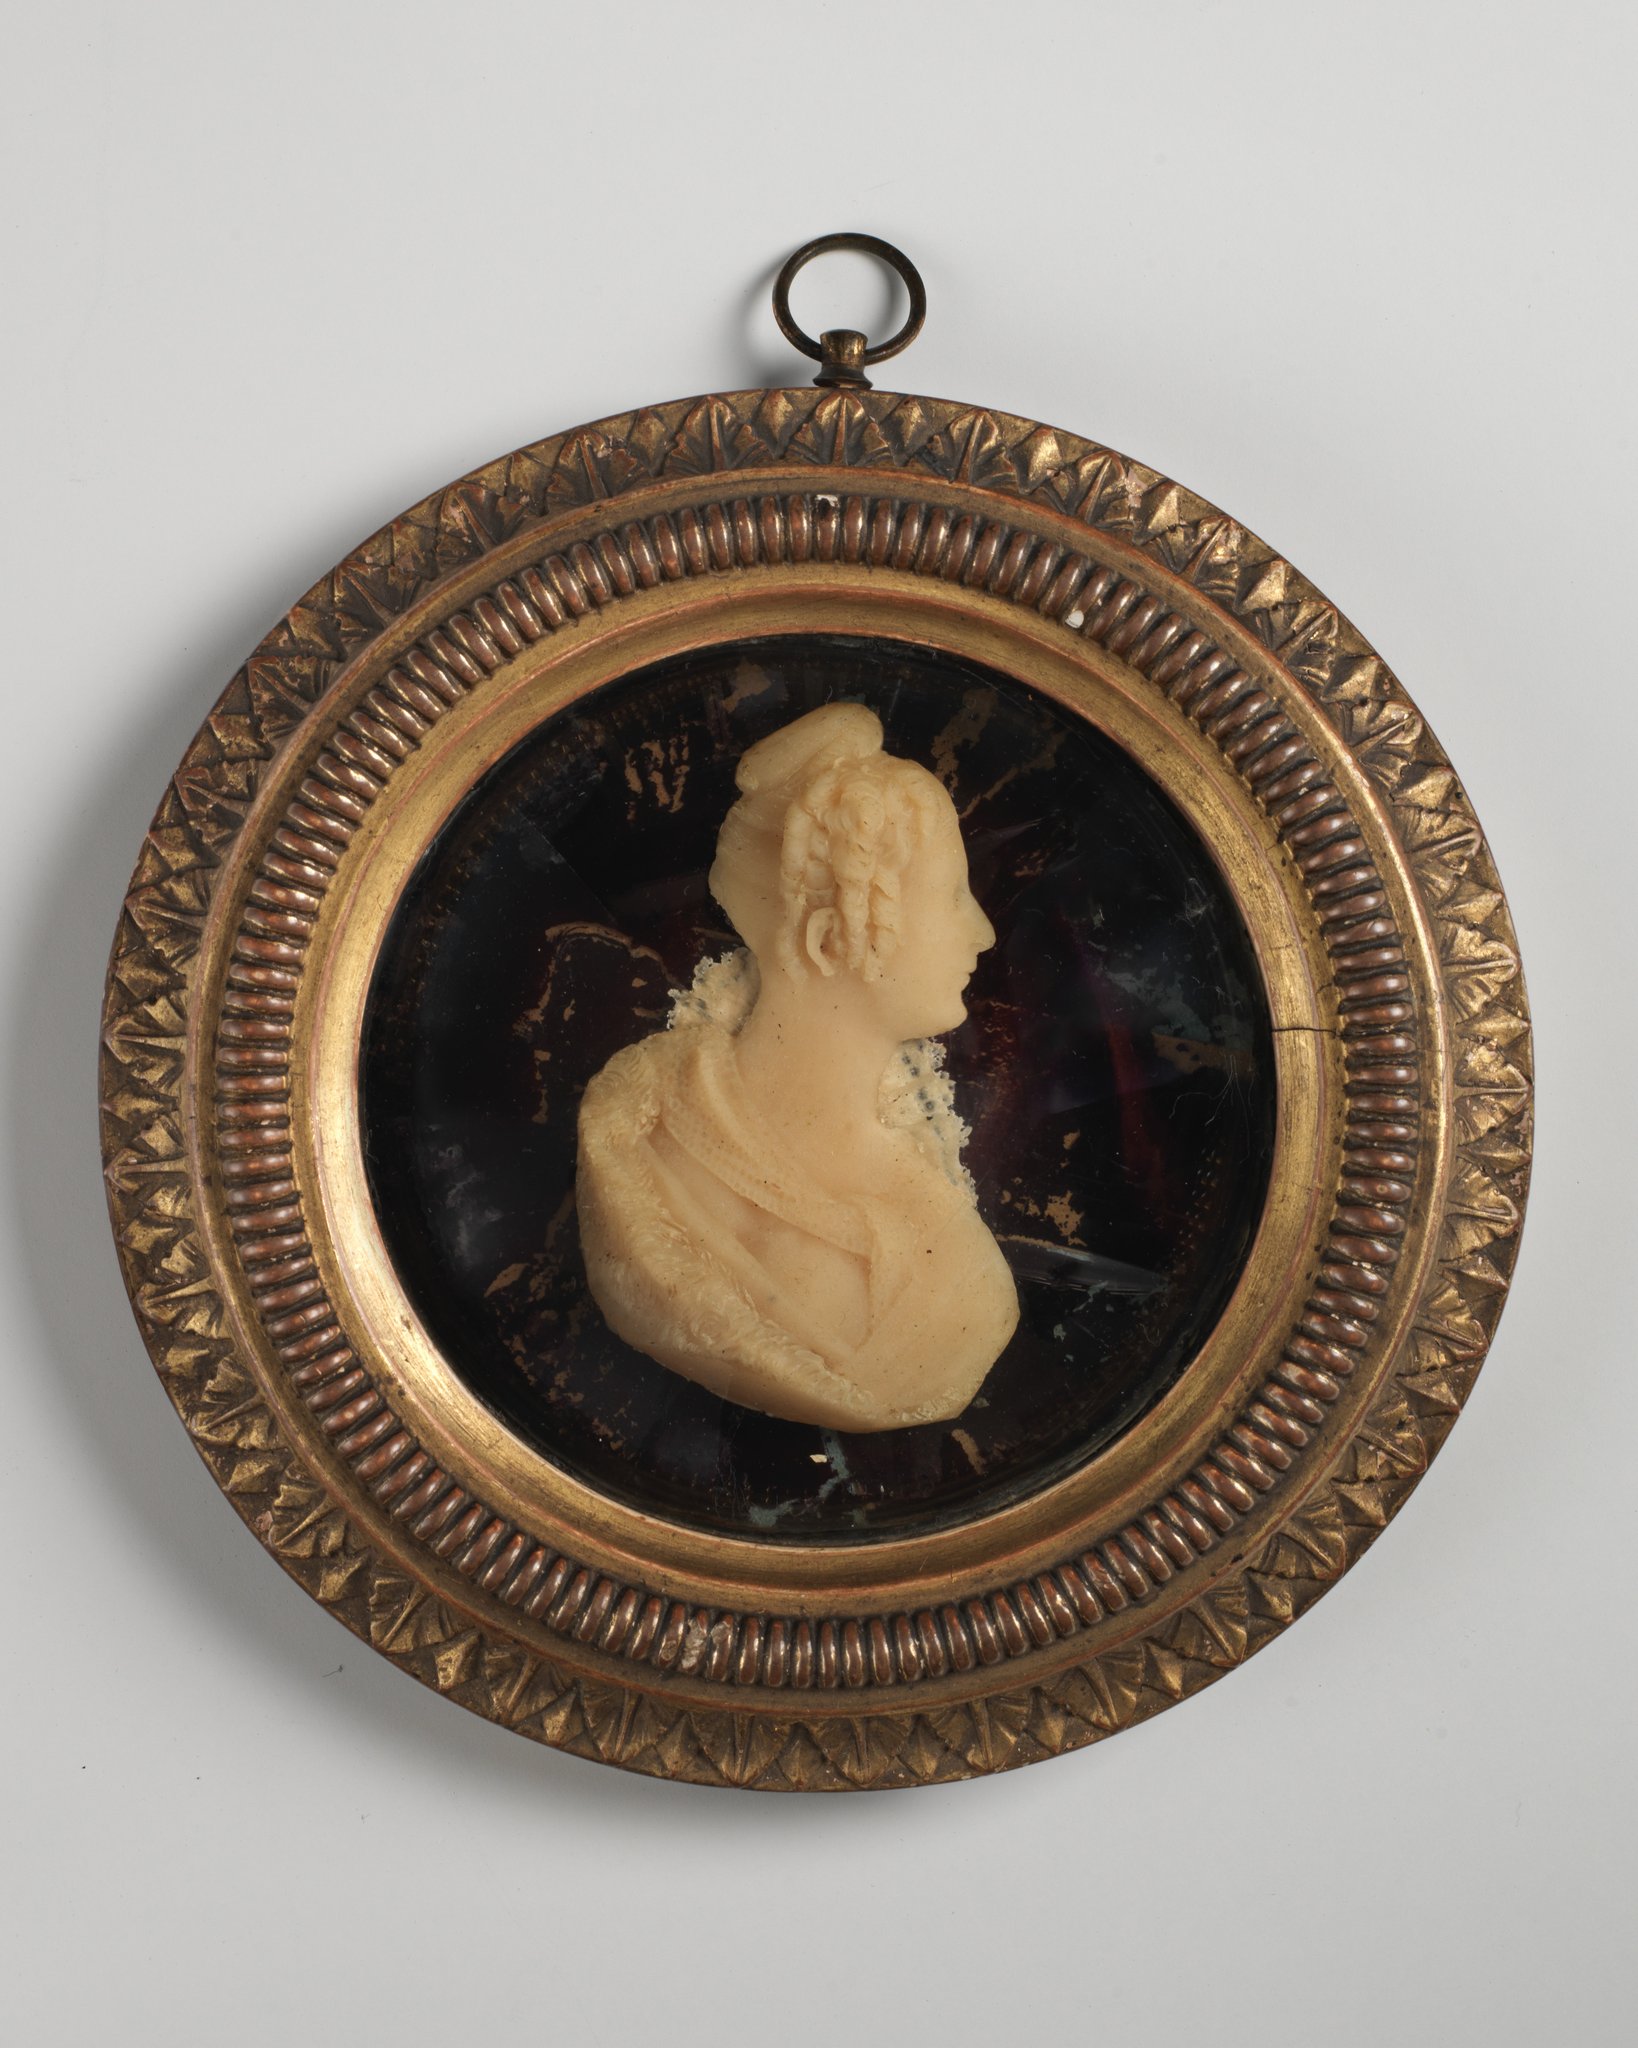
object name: medallion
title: Portrait of a lady, possibly Mrs. Timothy Shelley, Mother of Percy Byron Shelley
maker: samuel percy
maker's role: maker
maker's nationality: irish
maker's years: 1750-1820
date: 1801-1833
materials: glass, gold, wax, wood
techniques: painting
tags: profiles,women